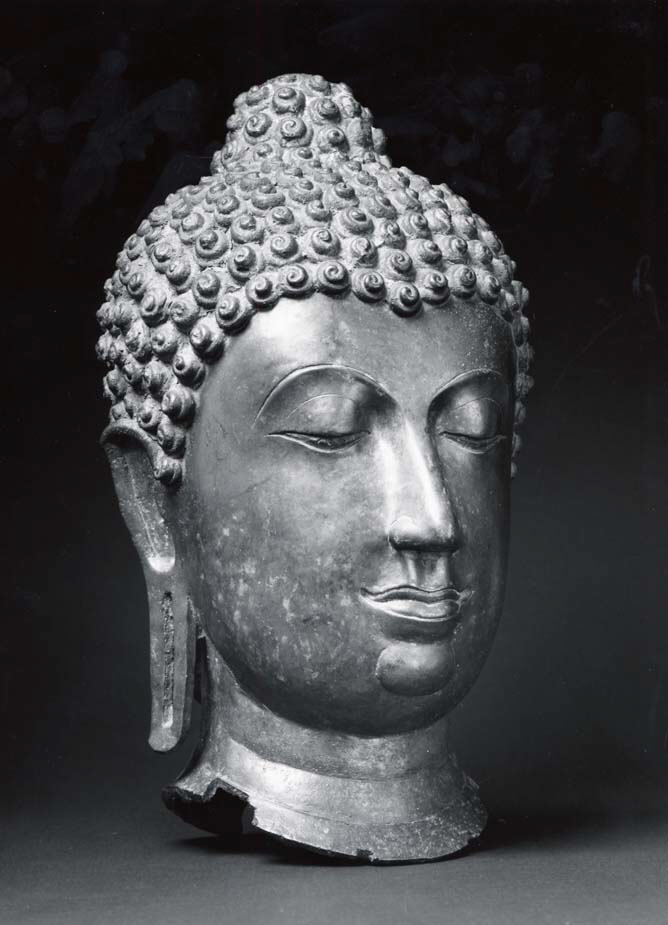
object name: head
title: Head of Buddha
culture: thailand, sukhothai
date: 1301-1500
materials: bronze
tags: heads,buddhism,buddha